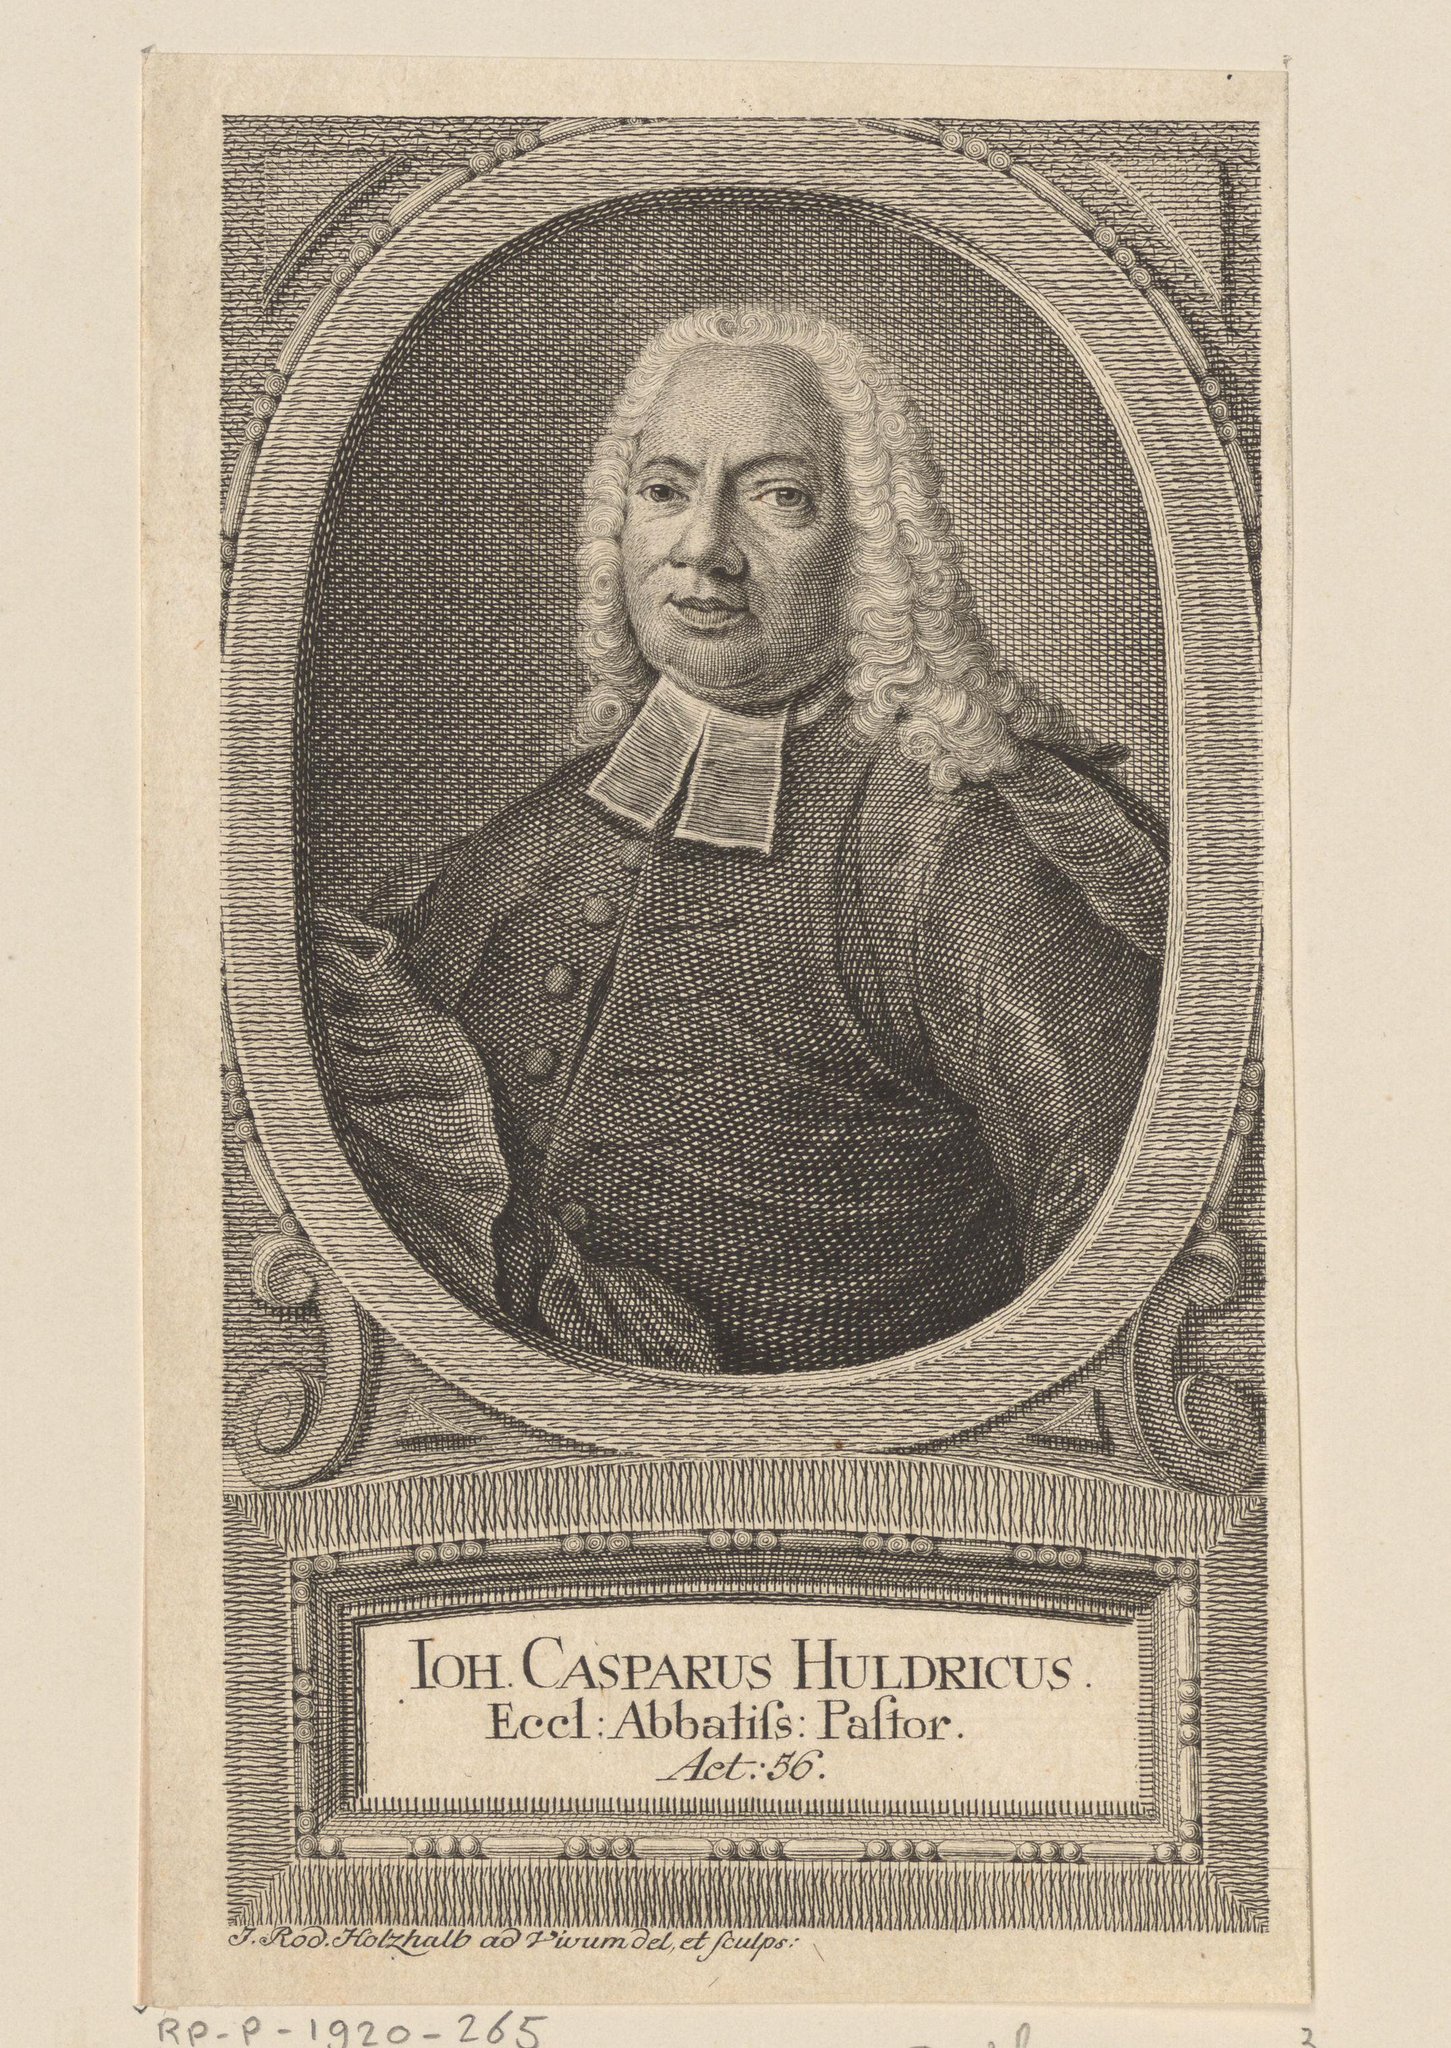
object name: print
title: Portret van Johann Caspar Ulrich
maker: johann rudolph holzhalb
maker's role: print maker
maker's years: 1723-1806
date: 1784-1806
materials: paper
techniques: engraving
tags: johann caspar ulrich, theologian, historical persons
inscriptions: collector's mark: Lugt 2228